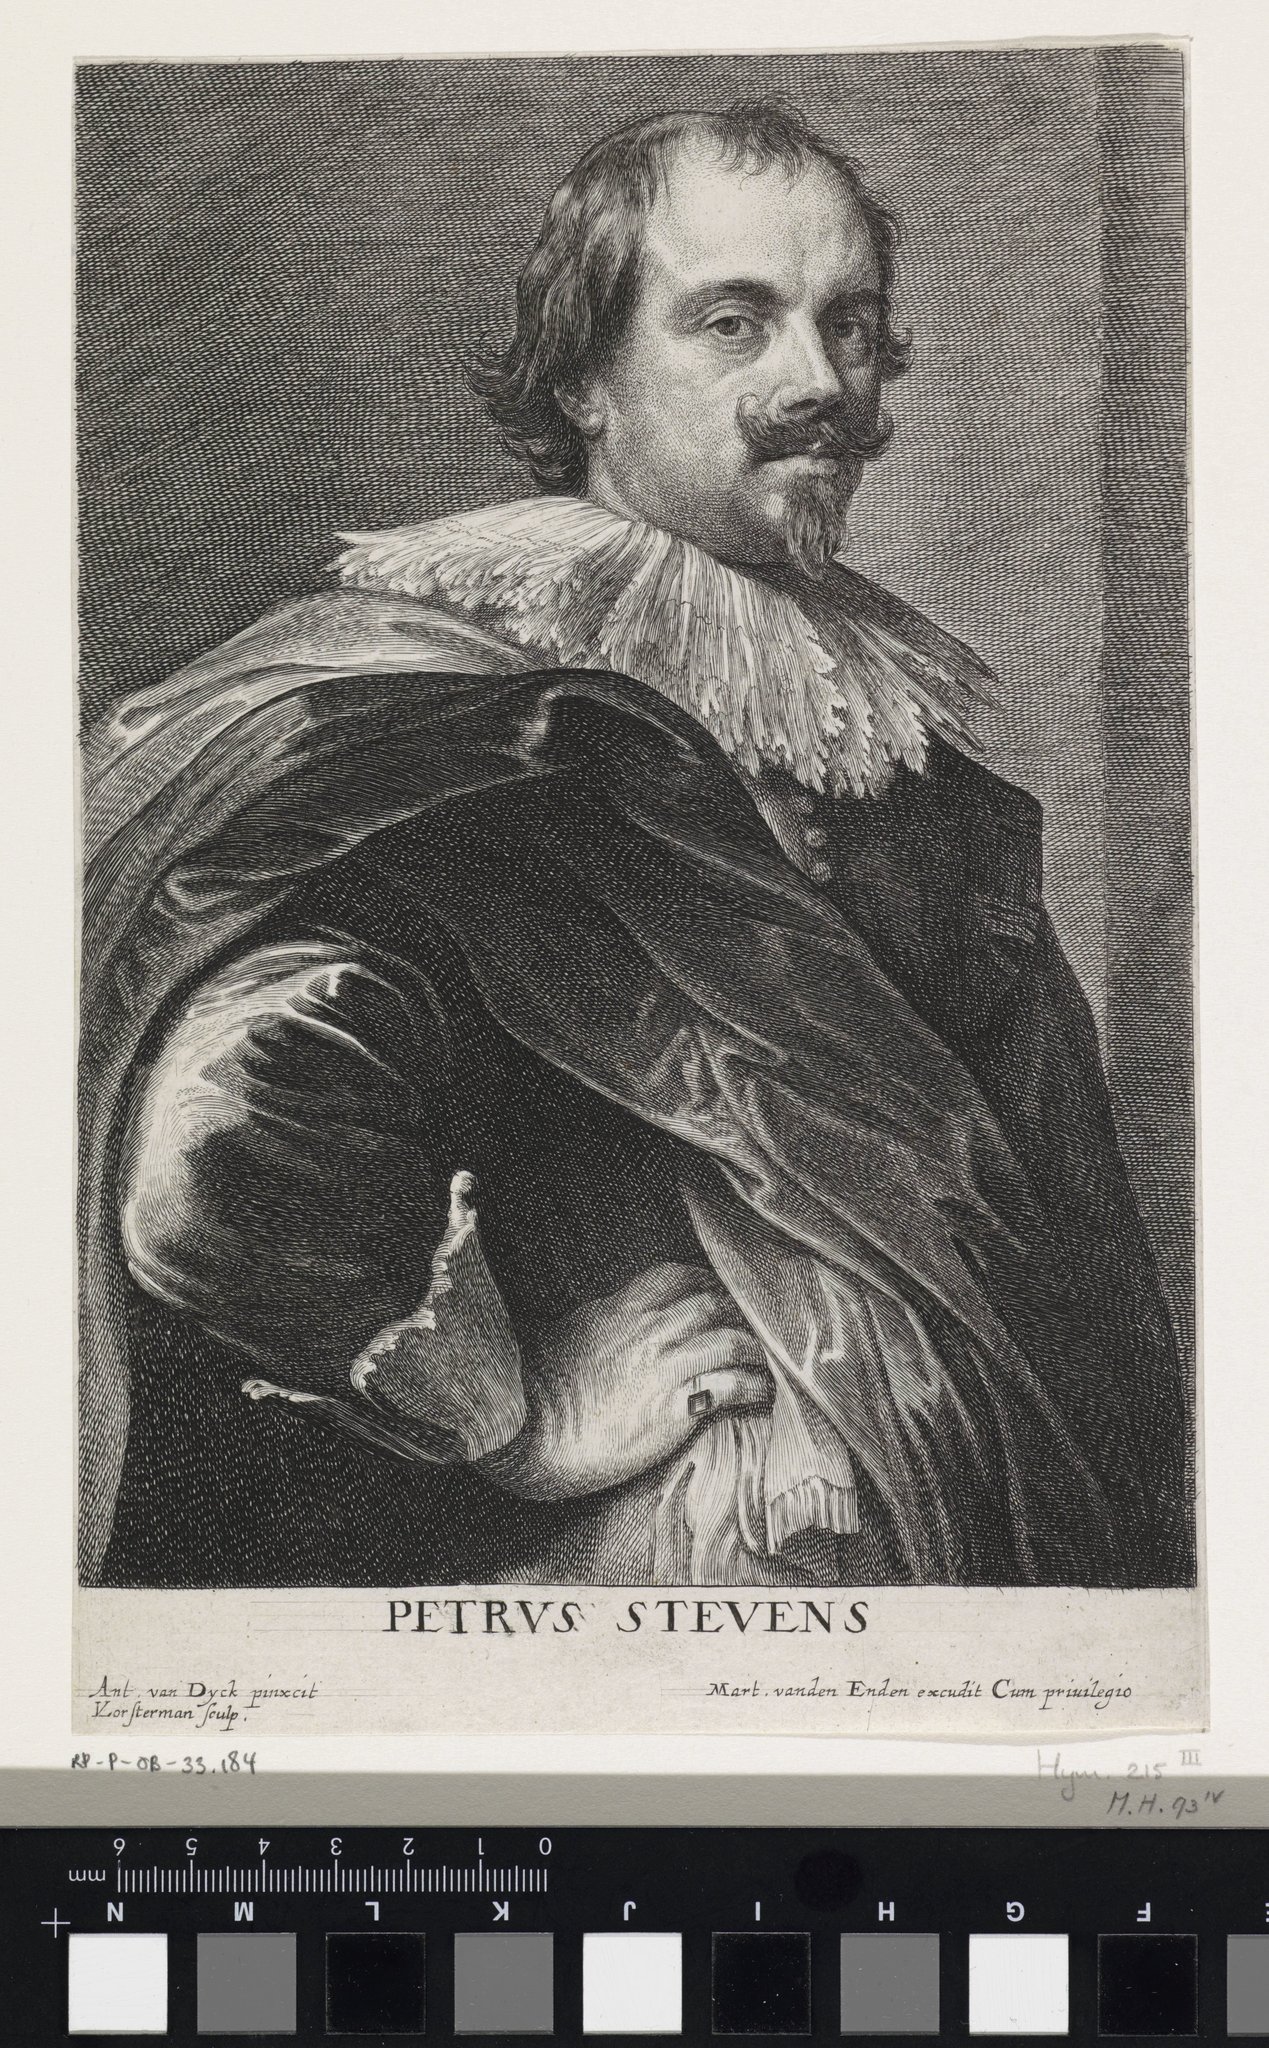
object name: print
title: Iconographie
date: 1630-1646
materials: paper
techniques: engraving, etching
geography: antwerp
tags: antwerp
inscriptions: collector's mark: Lugt 240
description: Prent gebruikt voor: Icones principum, virorum doctorum, pictorum, chalcographorum, statuariorum nec non amatorum pictoriae artis numero centum ab Ant. van Dyck ad vivum expressae ejusque sumptibus aeri incisae. Antwerpen: Gillis Hendricx, [1645-1646].